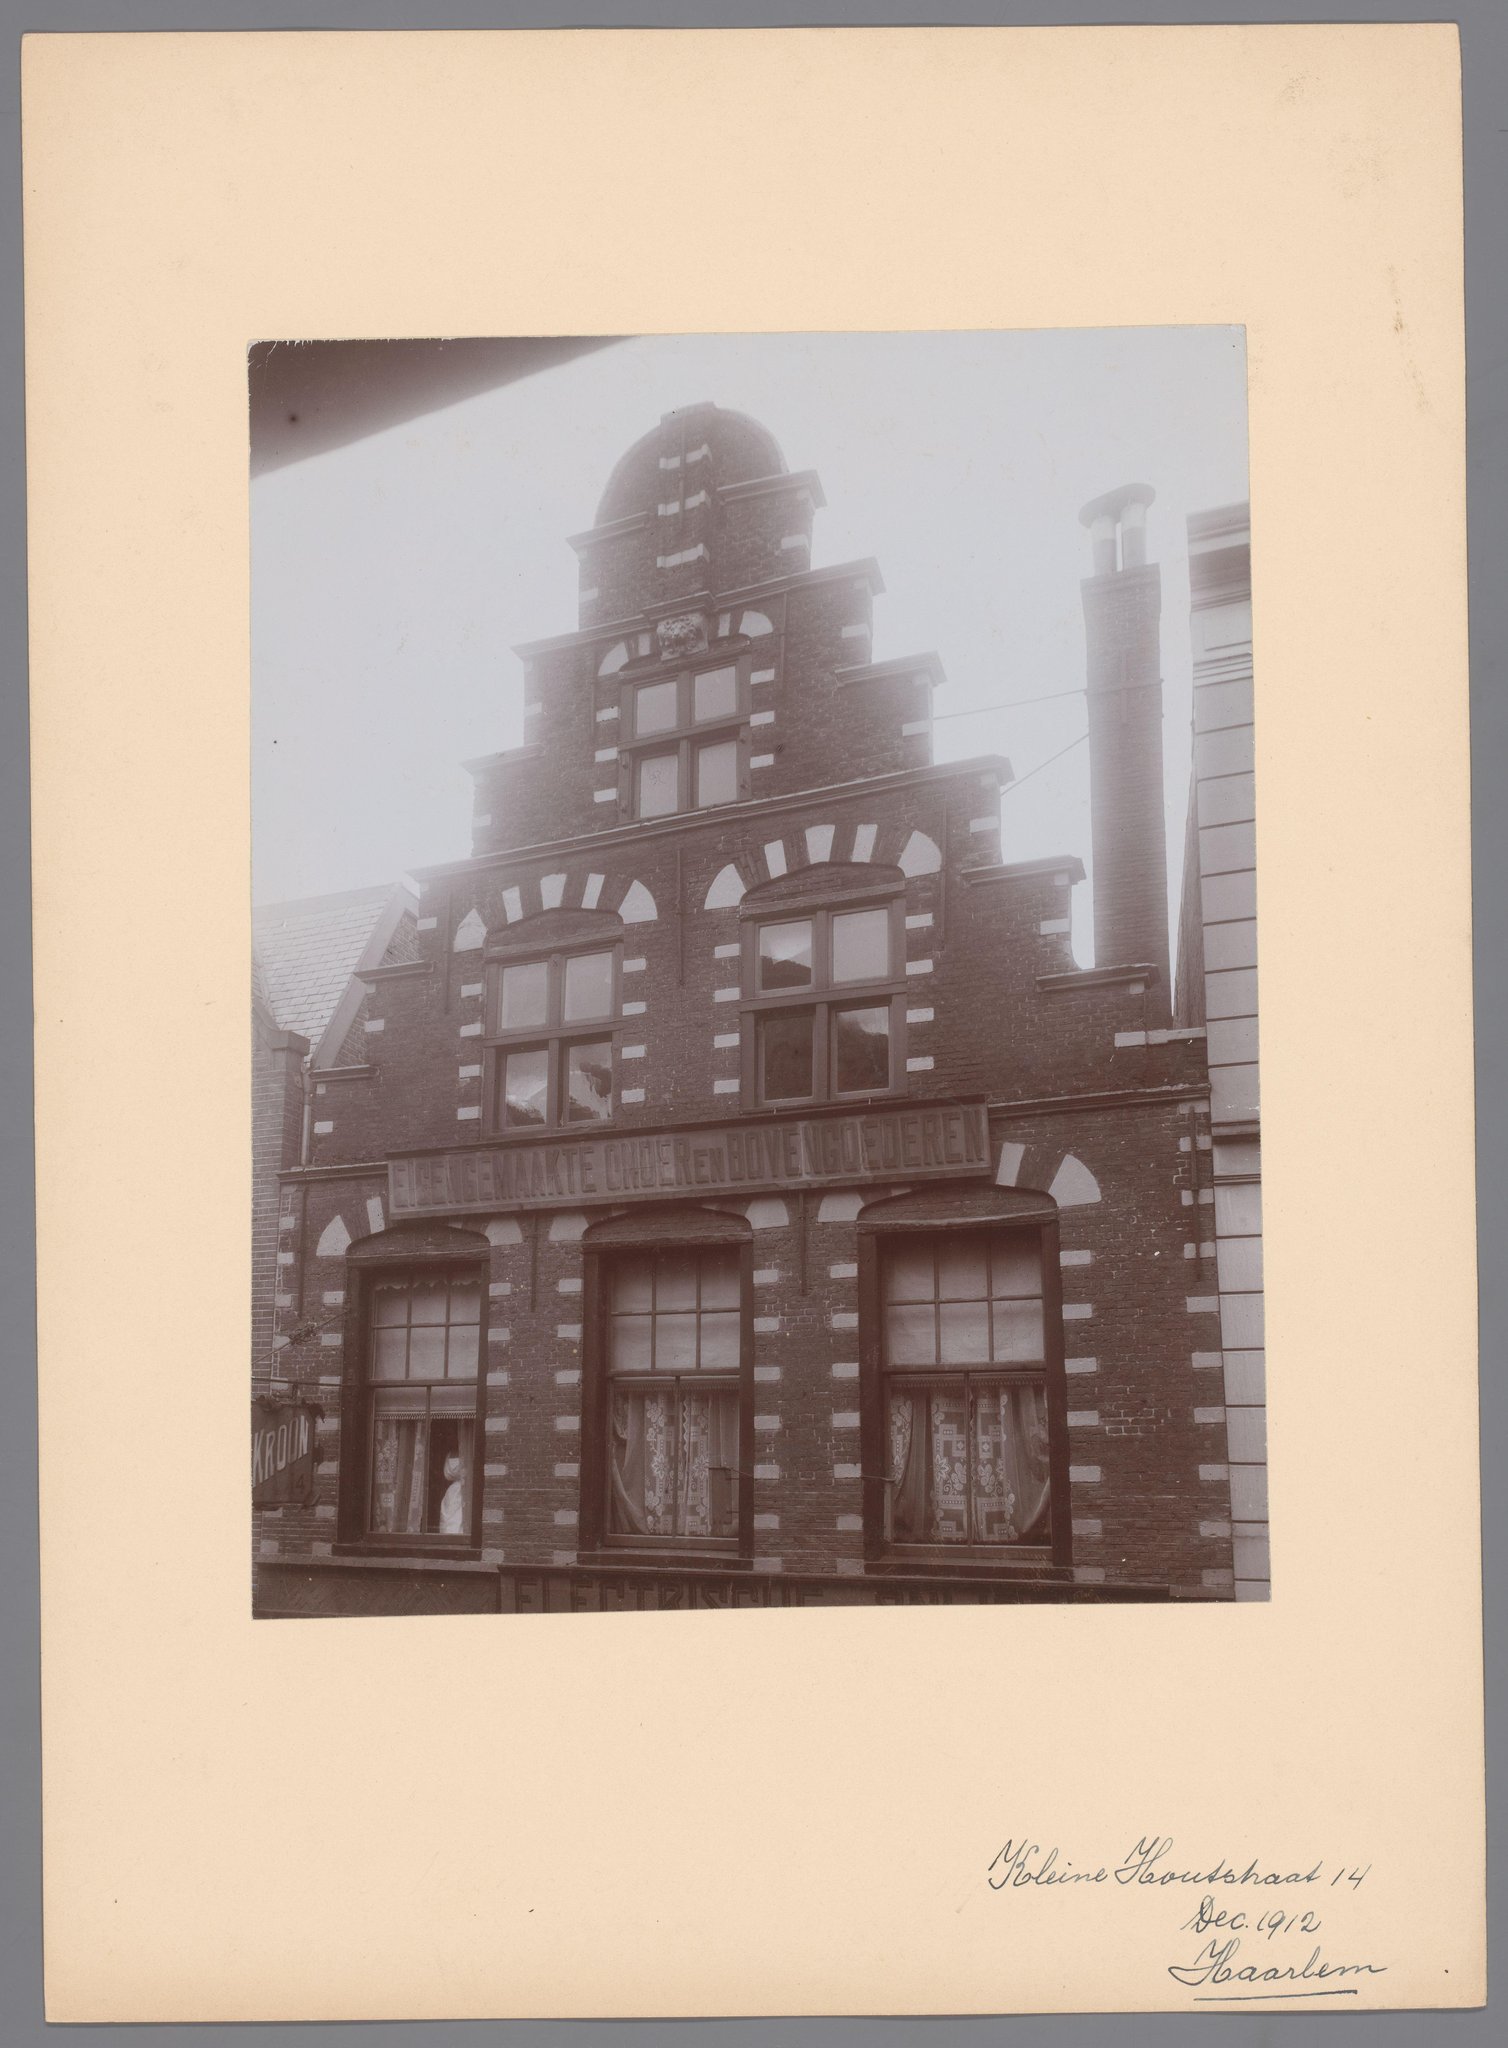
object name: photograph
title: Façade van Kleine Houtstraat 14 te Haarlem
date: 1912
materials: cardboard, photographic support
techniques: collodion silver print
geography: kleine houtstraat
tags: shop, store, façade (of house or building)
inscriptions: annotation: ‘Kleine Houtstraat 14/ Dec. 1912/ Haarlem’